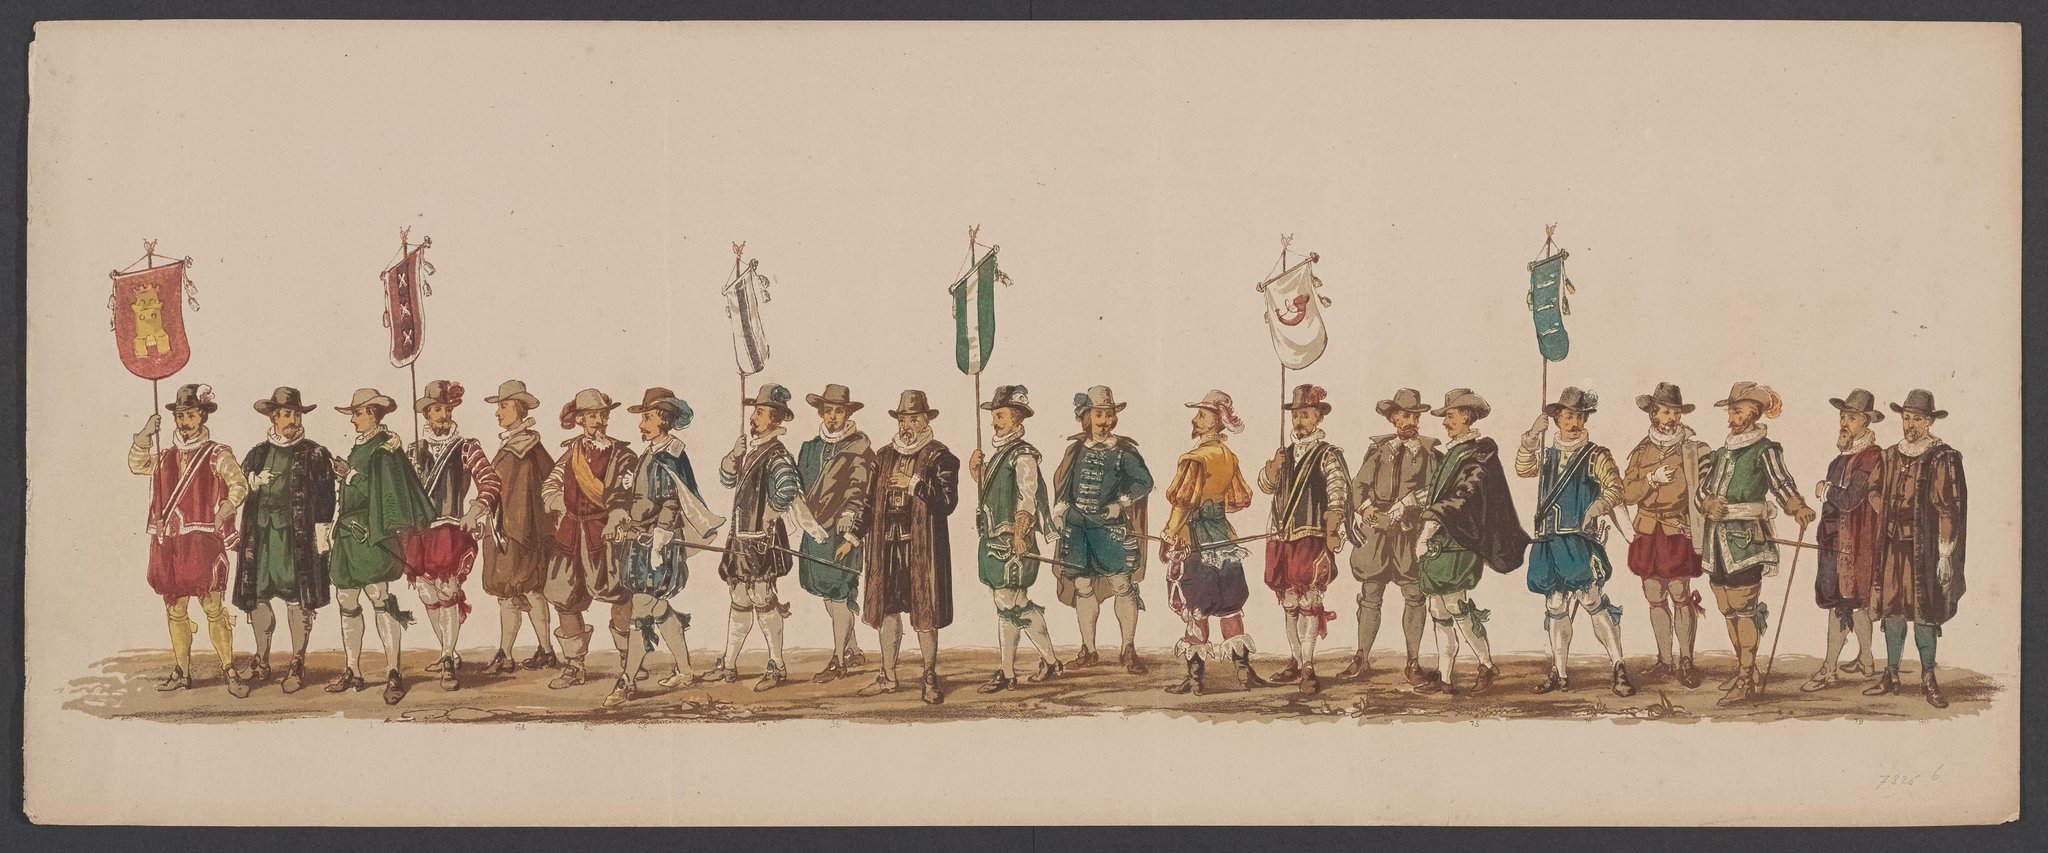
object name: print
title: Vierde Lustrum der Koninklijke Academie te Delft - Ao. 1862 - Gekostumeerde Optogt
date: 1862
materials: paper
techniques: chromolithography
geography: netherlands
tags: students' pageant, costumes used in pageants, commemoration of the founding of a university, delft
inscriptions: collector's mark: Lugt 2228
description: Vijfde groep: staatslieden en militairen te voet, genummerd 59-80. Onderdeel van de serie van acht platen van de gekostumeerde optocht gehouden door de studenten van de Koninklijke Academie te Delft bij het vierde lustrum op 8 juni 1862, plus intekenlijst en ledenlijst. De stoet stelt voor het gezantschap van de sultan van Atjeh aan prins Maurits en de Staten op 4 september 1602.